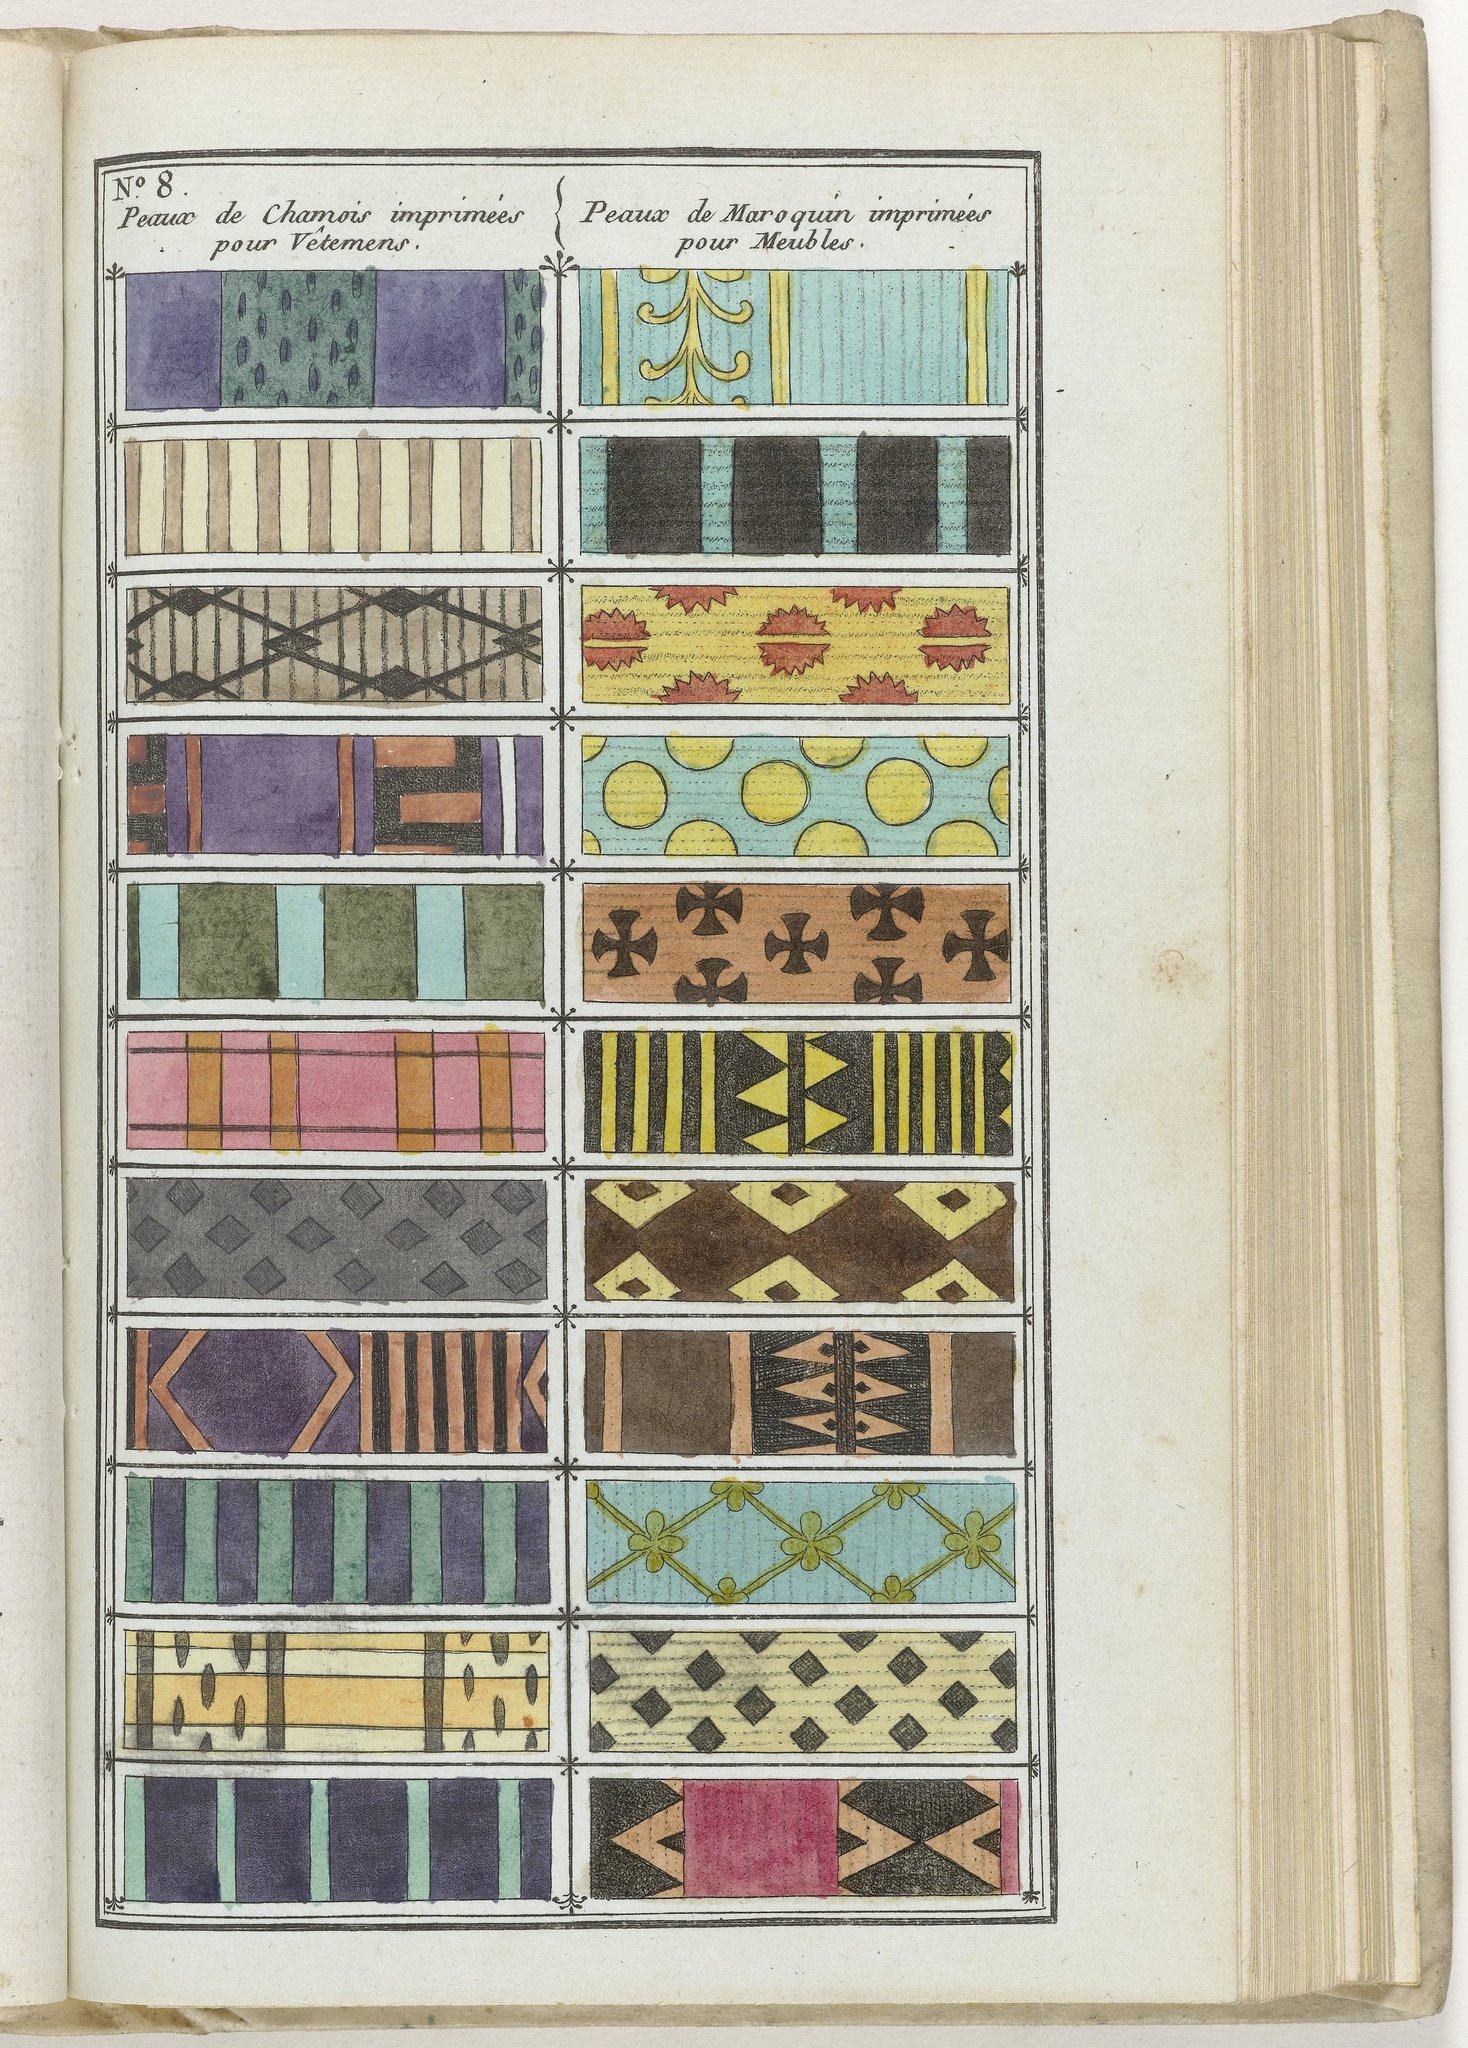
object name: print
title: Le Mois : Journal historique, littéraire et critique avec figures, Tome 3, No. 8, An. 8 (1799-1800): Peaux de Chamois...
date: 1799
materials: paper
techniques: etching, hand coloring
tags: clothes manufacture, clothing industry, materials ~ textile industry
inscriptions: inscription: ‘Peaux de Chamois imprimées pour vêtemens. / Peaux de Maroquin imprimées pour Meubles.’, inscription: ‘No. 8’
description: Twee kolommen met 11 verschillende stoffen; links voor kleding, rechts voor meubels. Genummerd: 8. Prent uit het tijdschrift Le Mois : Journal historique, littéraire et critique avec figures, An 7 en 8 (1798-1800).